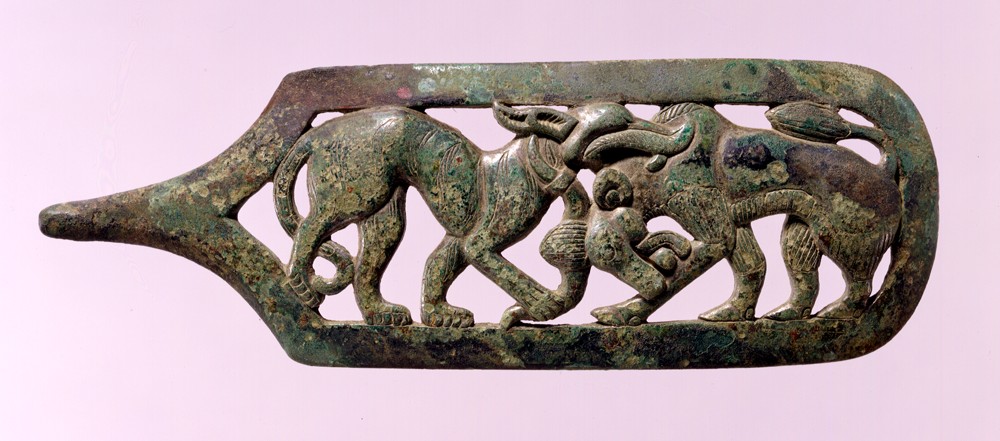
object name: belt hook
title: Belt Hook with Wolf and Dzo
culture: northwest chinese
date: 300-201 BCE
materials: bronze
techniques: gilding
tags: animals